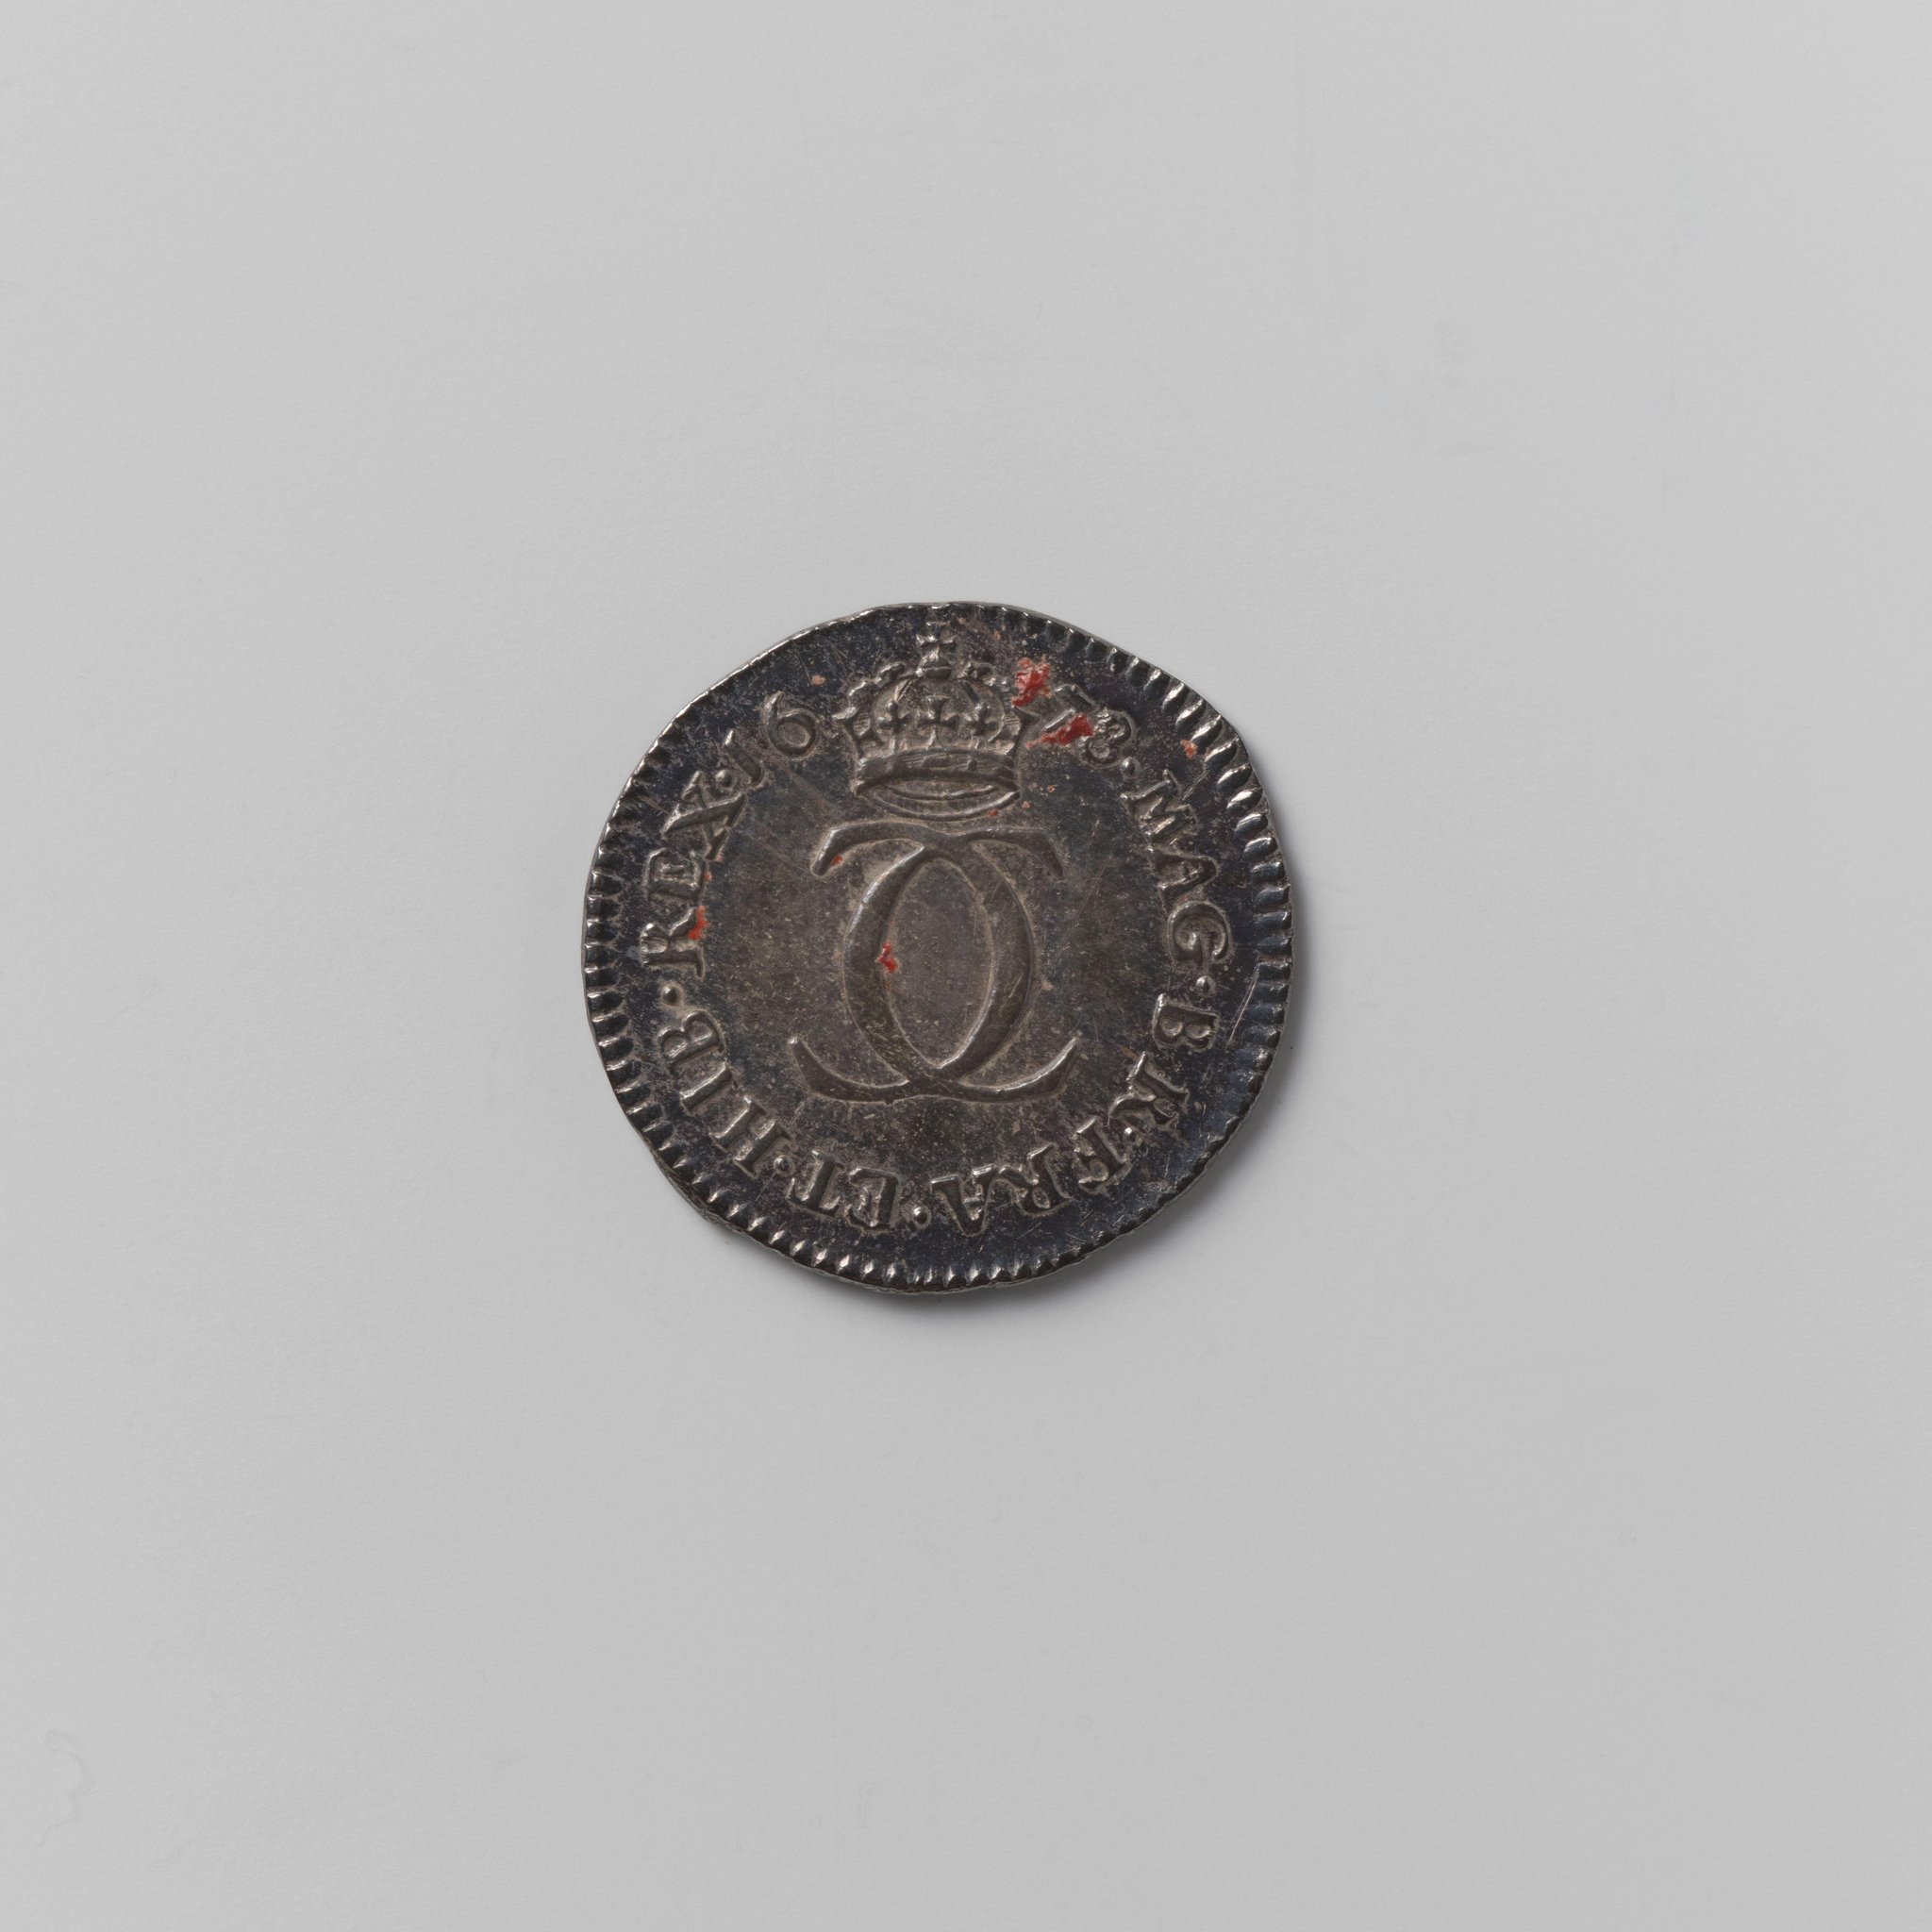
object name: coin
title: Engeland, Karel II, twopence, 1678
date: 1678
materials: silver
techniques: striking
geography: london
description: Zilveren munt. Voorzijde: gelauwerd borstbeeld van de koning naar rechts. Keerzijde: gekroond monogram van twee letters C. Jaartal bovenaan rondom kroon. Maundy money.